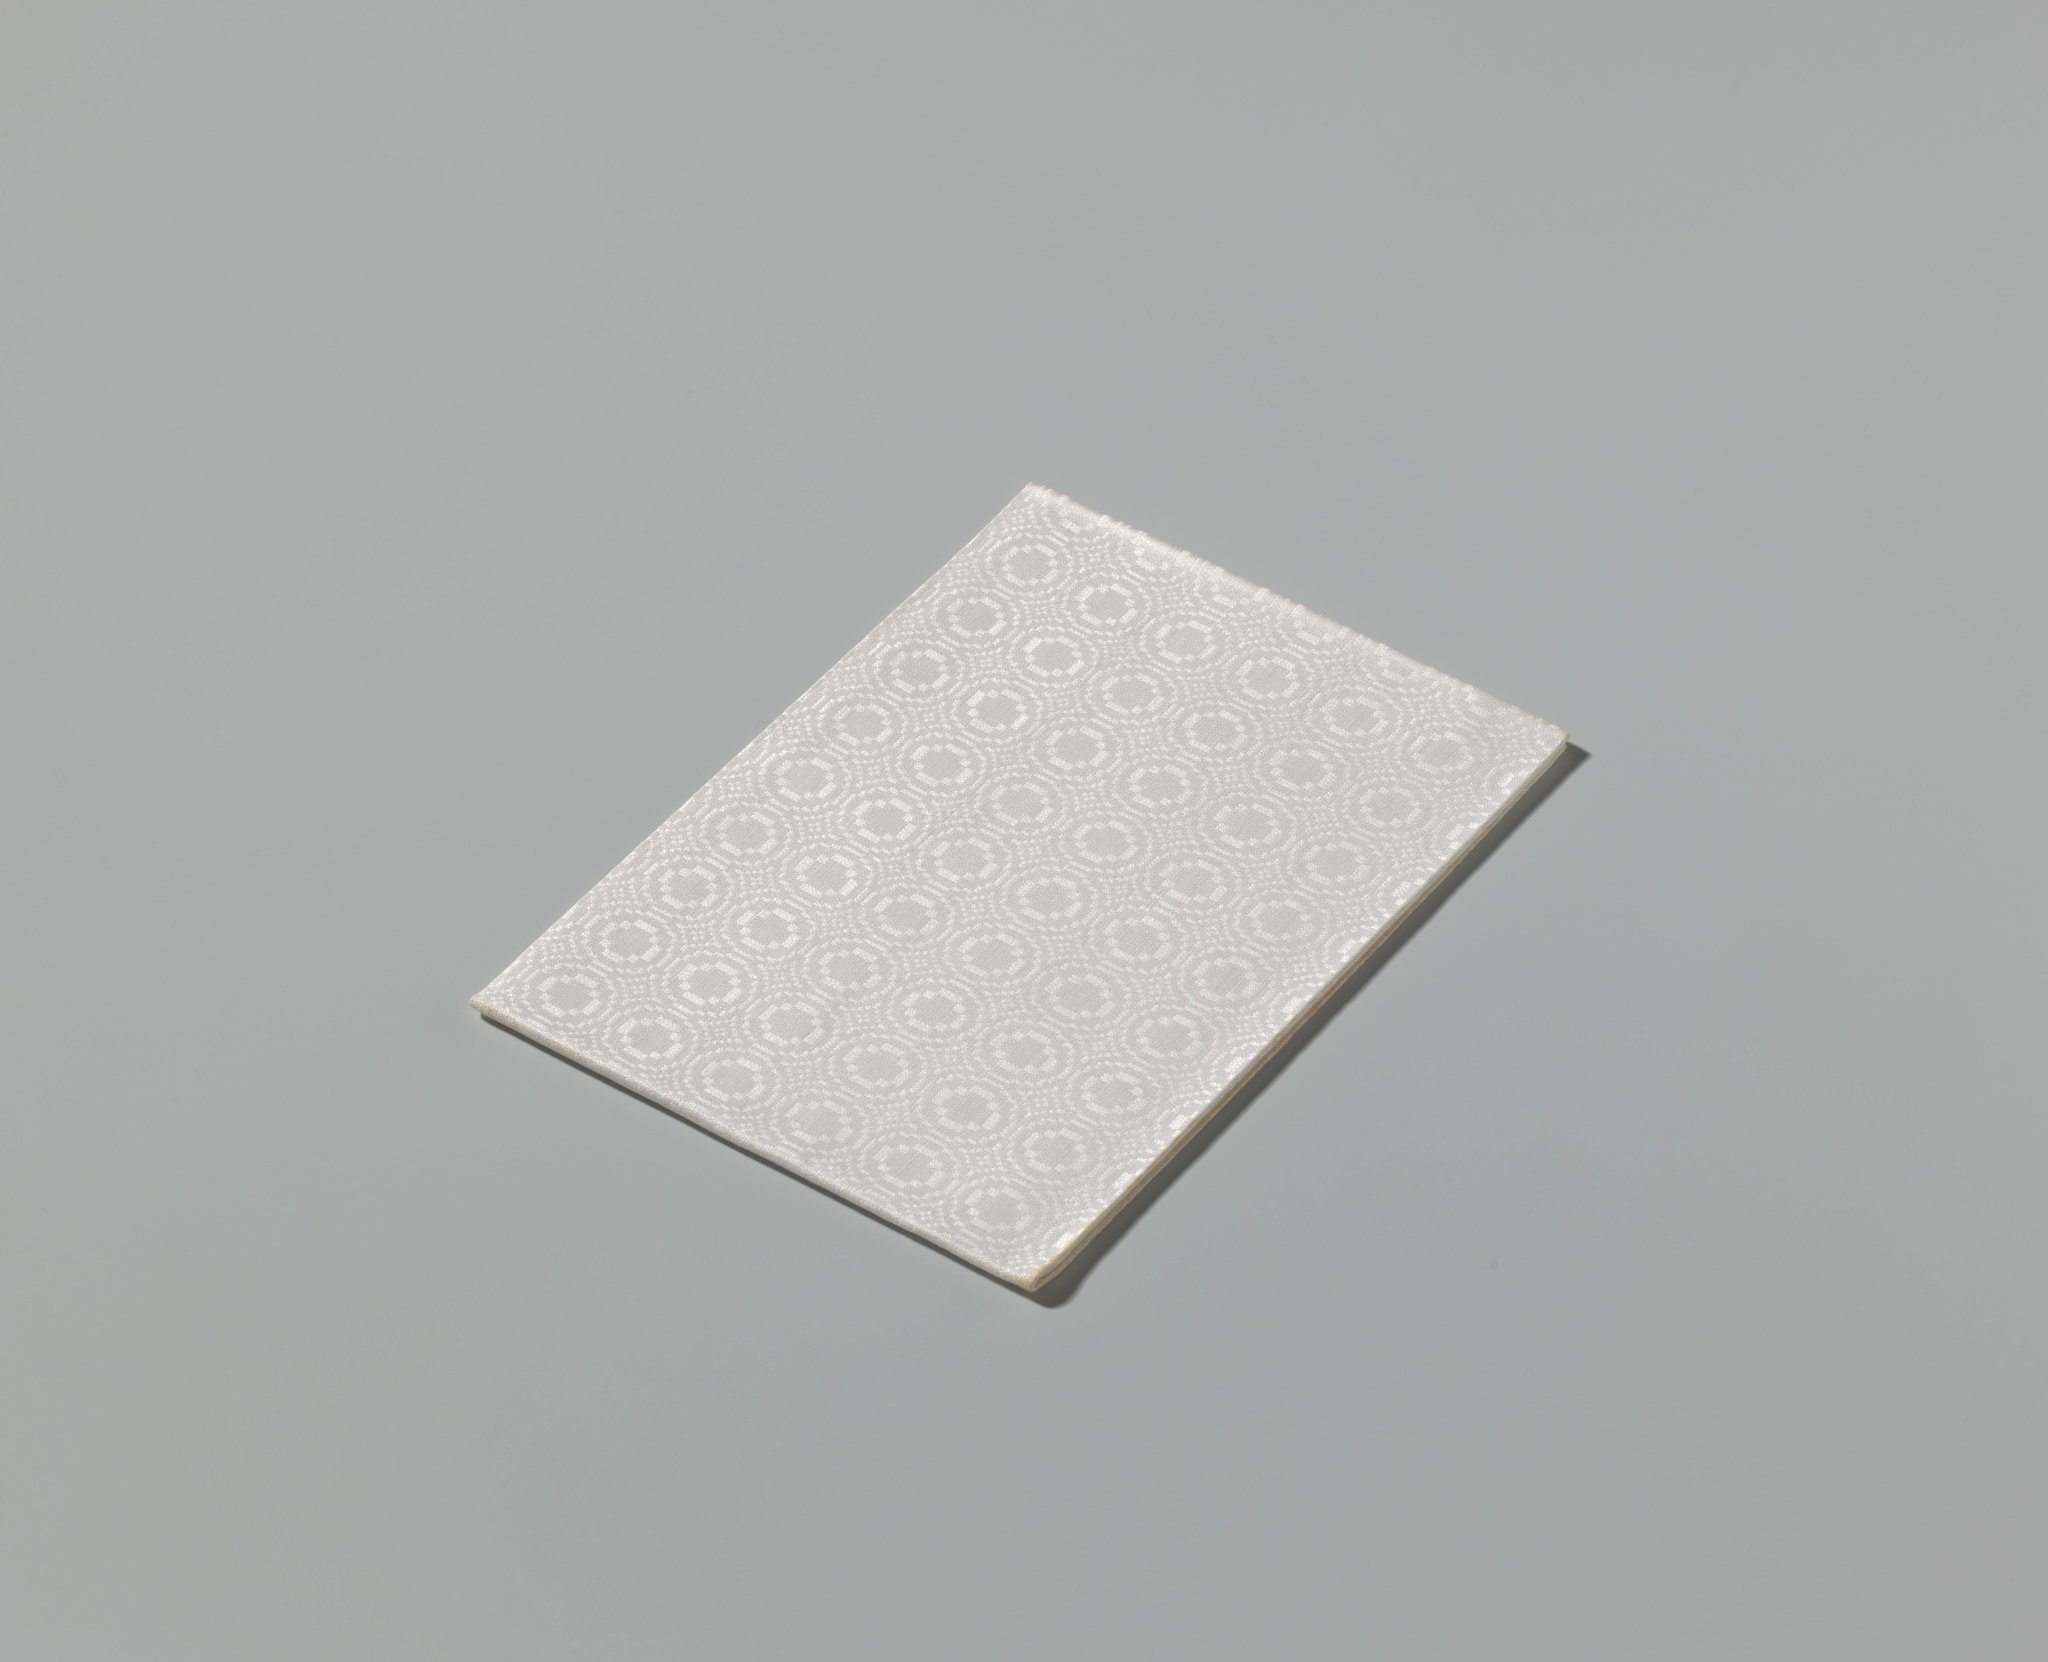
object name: napkin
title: Servet van linnen met pellenpatroon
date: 1600-1650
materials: linen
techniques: peeled fabric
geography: northern netherlands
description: wit linnen servet met pellen patroon, merk IVG